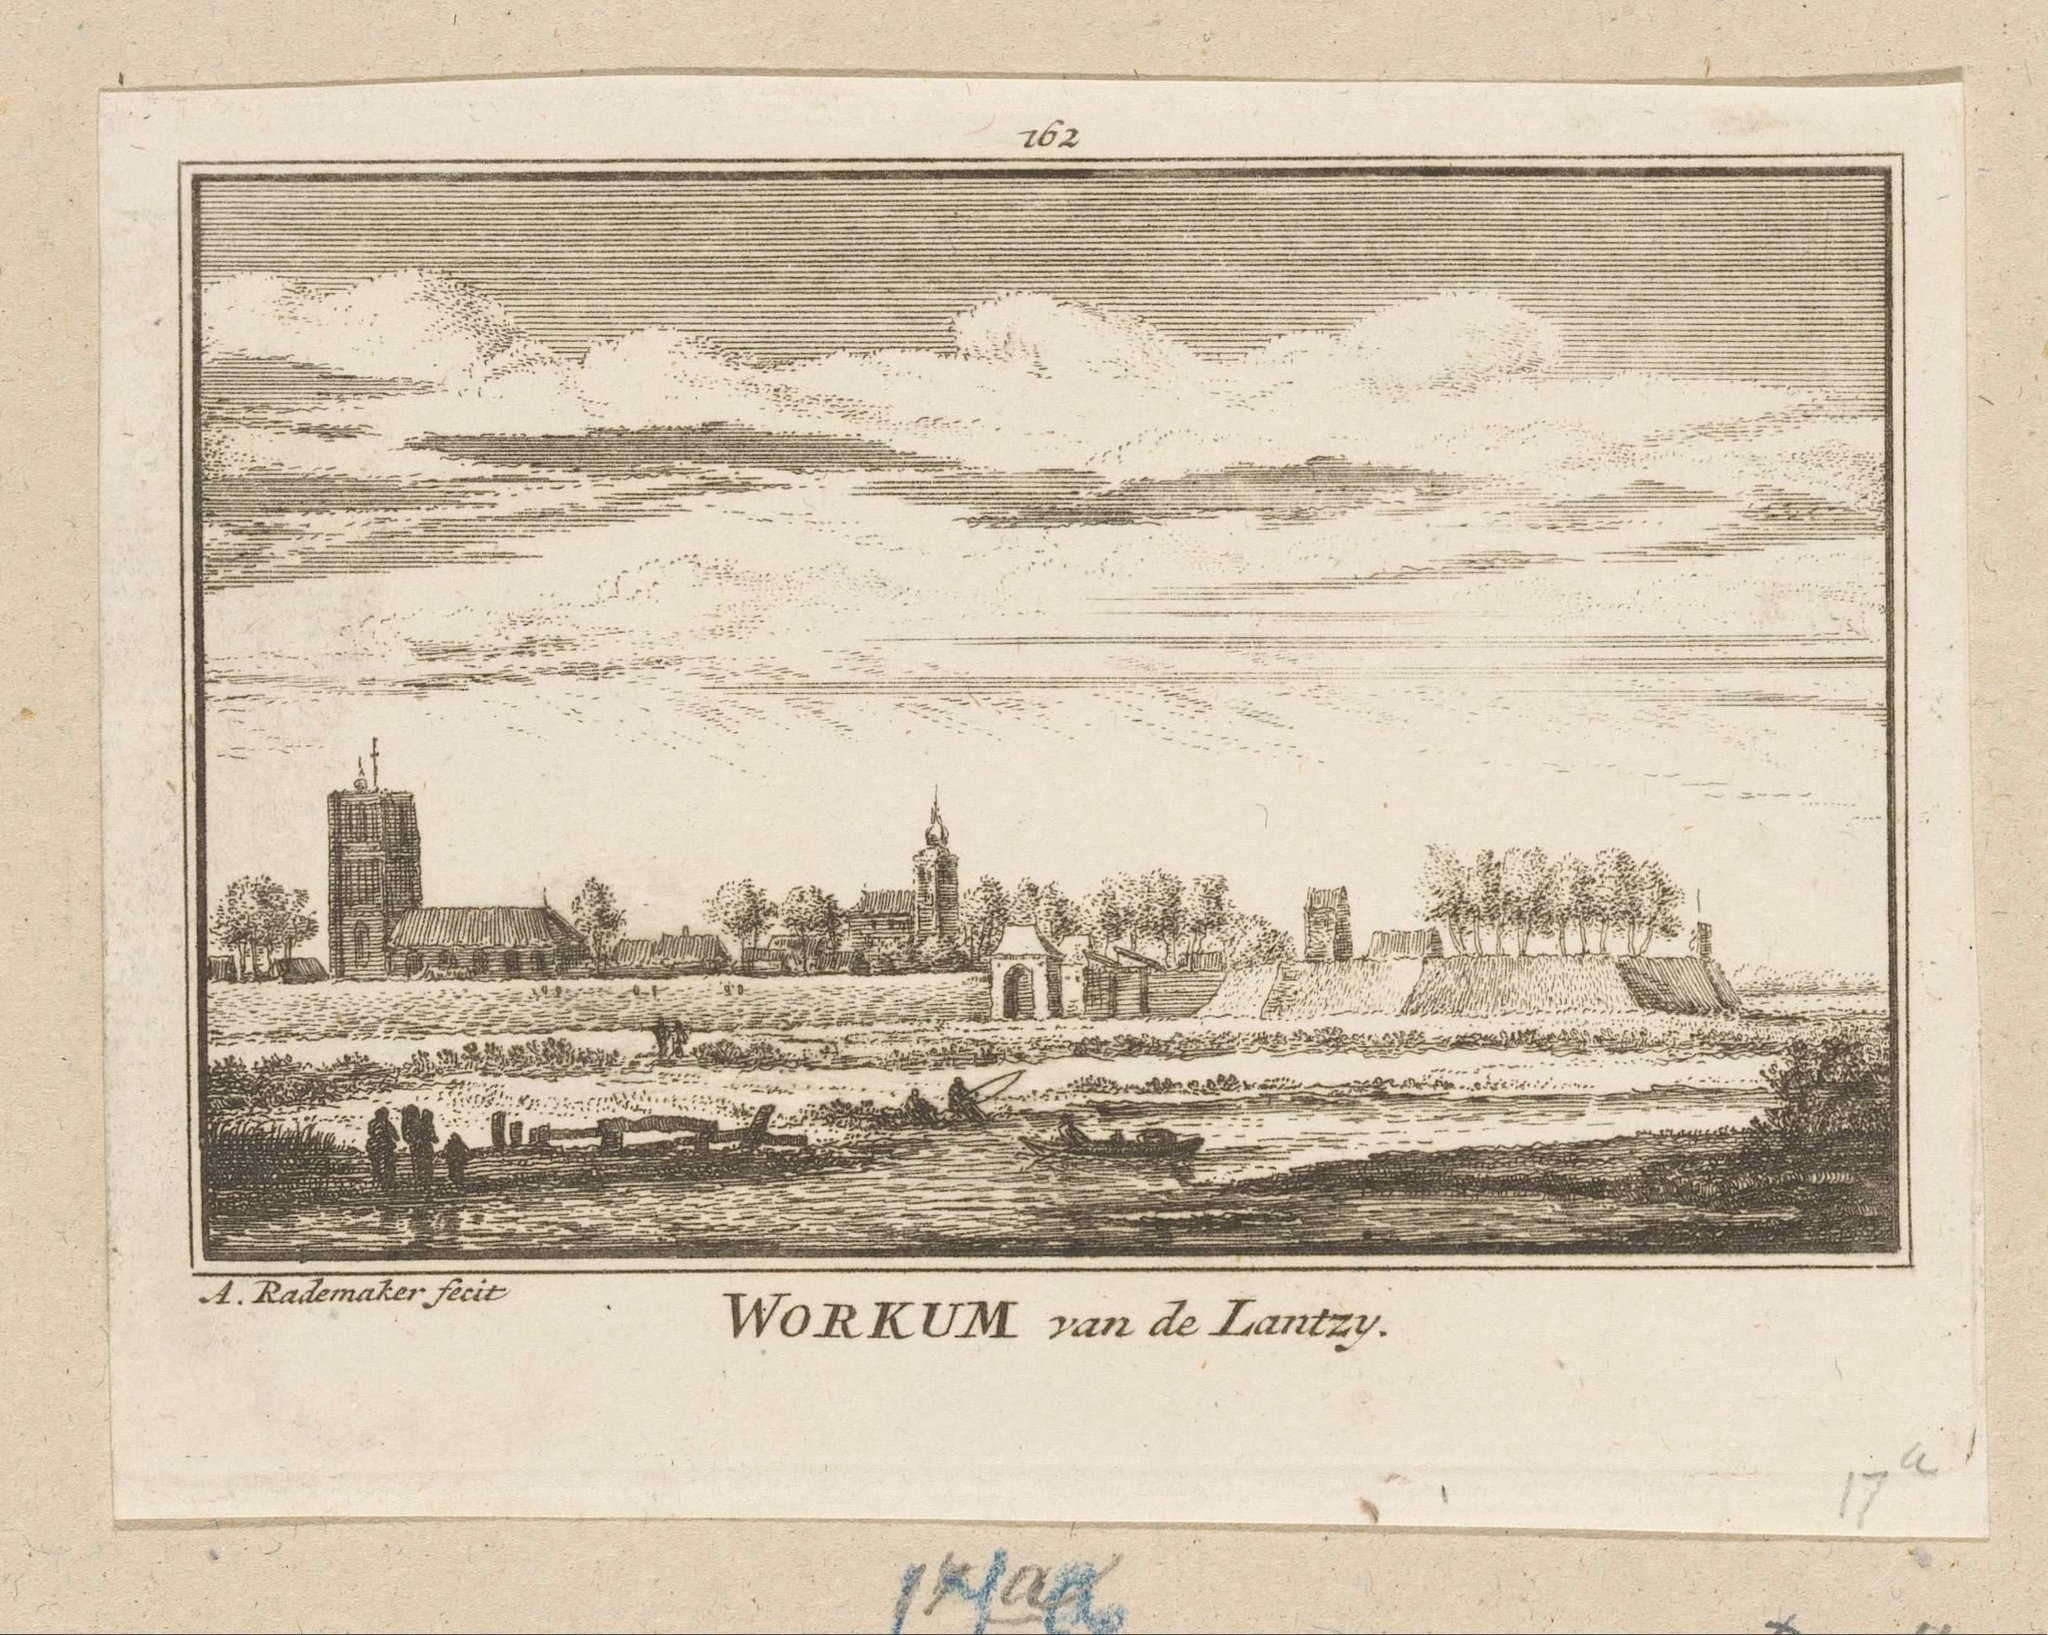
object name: print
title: Gezicht op Woudrichem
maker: abraham rademaker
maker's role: draughtsman, print maker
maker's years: 1676-1735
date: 1725-1803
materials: paper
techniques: engraving, etching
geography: amsterdam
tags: church (exterior), city-gate, prospect of city, town panorama, silhouette of city, fisherman, woudrichem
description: Prent ook gebruikt in: Rademaker, Abraham. Kabinet van Nederlandsche outheden en gezichten: vervat in 300 konstplaaten (…). 2 delen. Amsterdam: Willem Barents, 1725, dl. 2, ill. 162. Na 1725 is deze prent nog in verschillende heruitgaven verschenen, uitgegeven in 1727-1733, 1770-1771 en 1792-1803. Uit welke uitgave het huidige exemplaar precies komt is niet na te gaan.